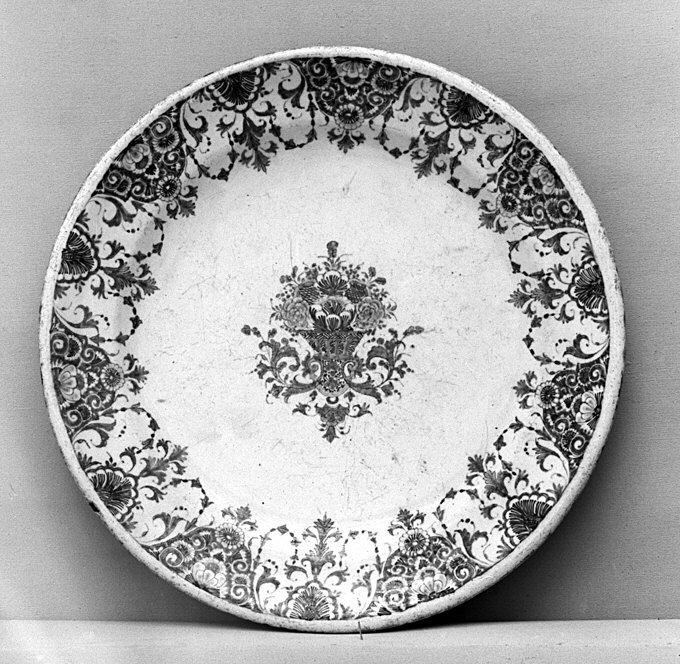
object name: plate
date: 1705-1720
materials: faience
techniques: glazing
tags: flowers